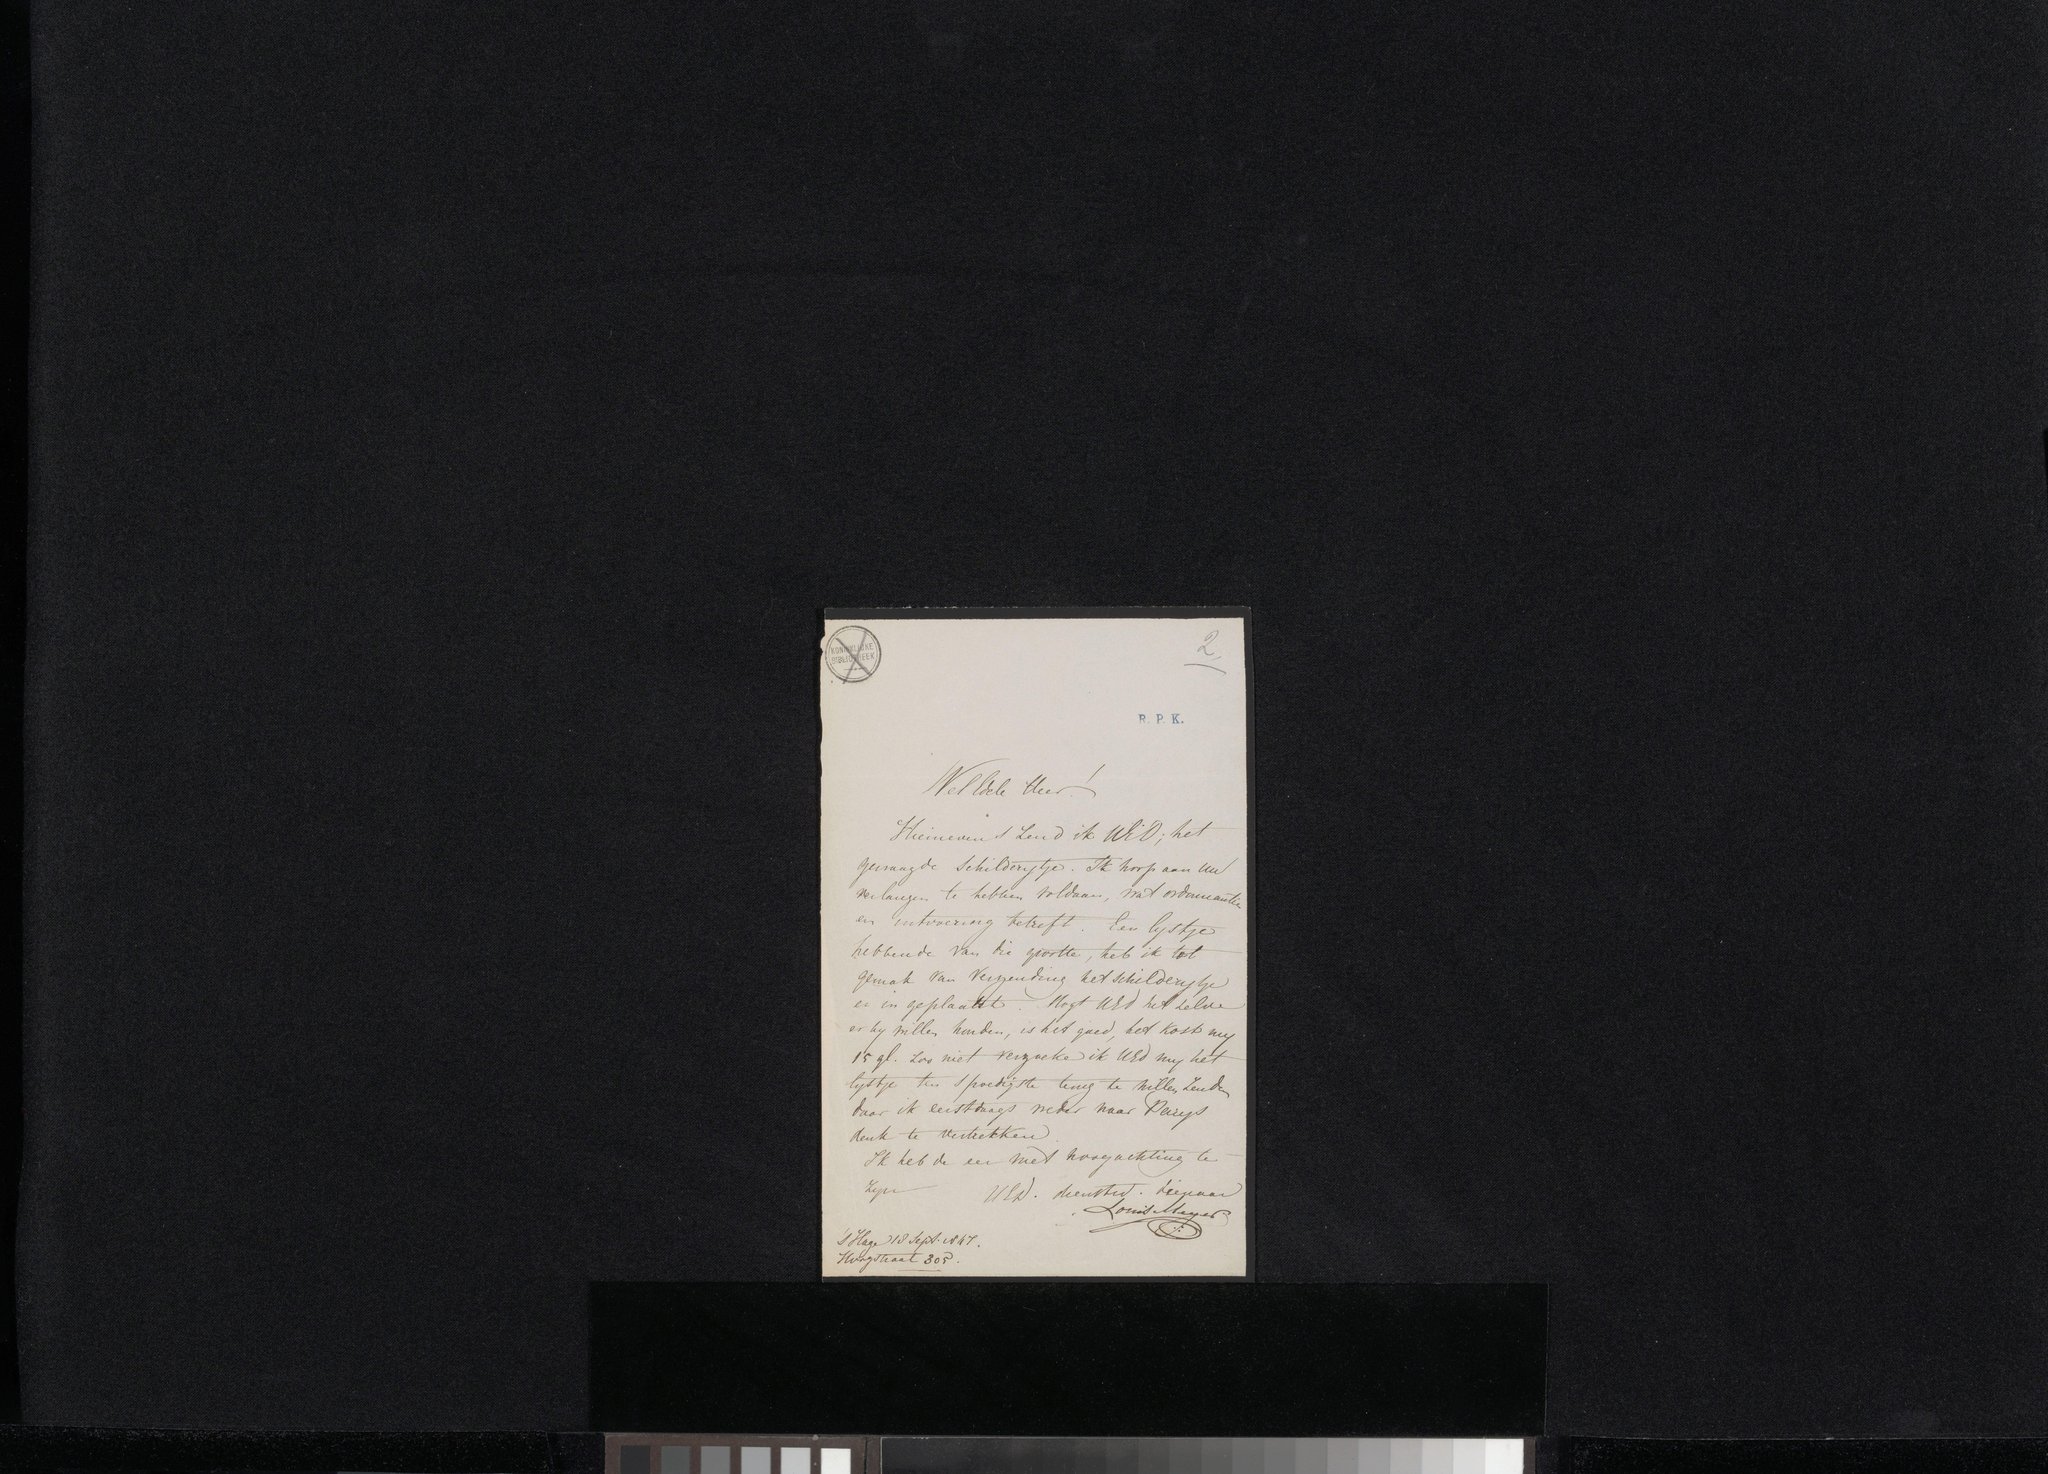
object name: letter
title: Brief aan anoniem, mogelijk aan C.J. de Lang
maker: louis meijer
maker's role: draughtsman, painter, print maker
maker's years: 1809-1866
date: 1847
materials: ink, paper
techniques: pen, writing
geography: the hague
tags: painting (including book-illumination, miniature-painting), money, paris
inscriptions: collector's mark: Lugt 2233, collector's mark: ‘KONINKLIJKE BIBLIOTHEEK’